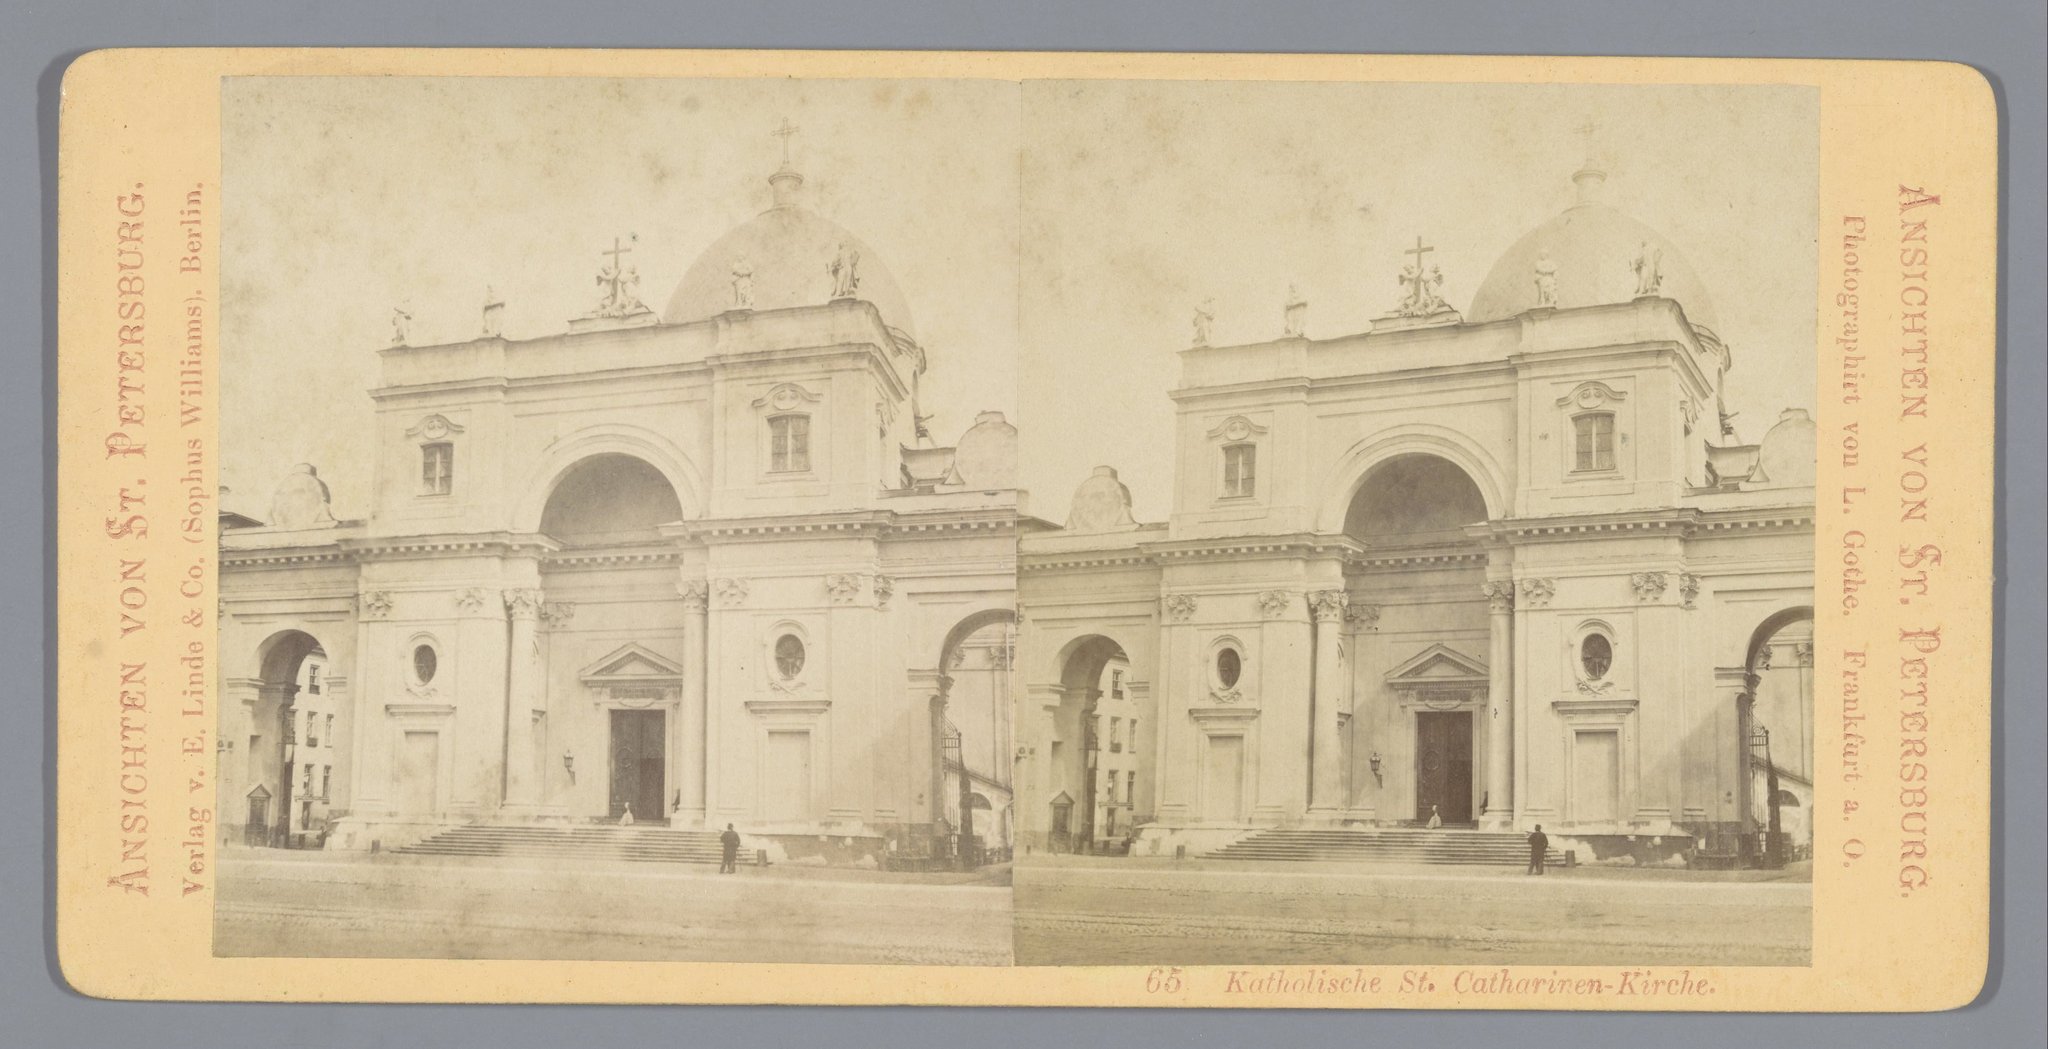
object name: stereograph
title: Gezicht op de katholieke Sint-Catharinakerk in Sint-Petersburg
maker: louis gothe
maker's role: fotograaf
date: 1850-1880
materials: cardboard, photographic support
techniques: albumen print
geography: sint-petersburg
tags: church (exterior), façade (of house or building)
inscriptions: number: ‘65.’, inscription: ‘Ansichten von St. Petersburg.’